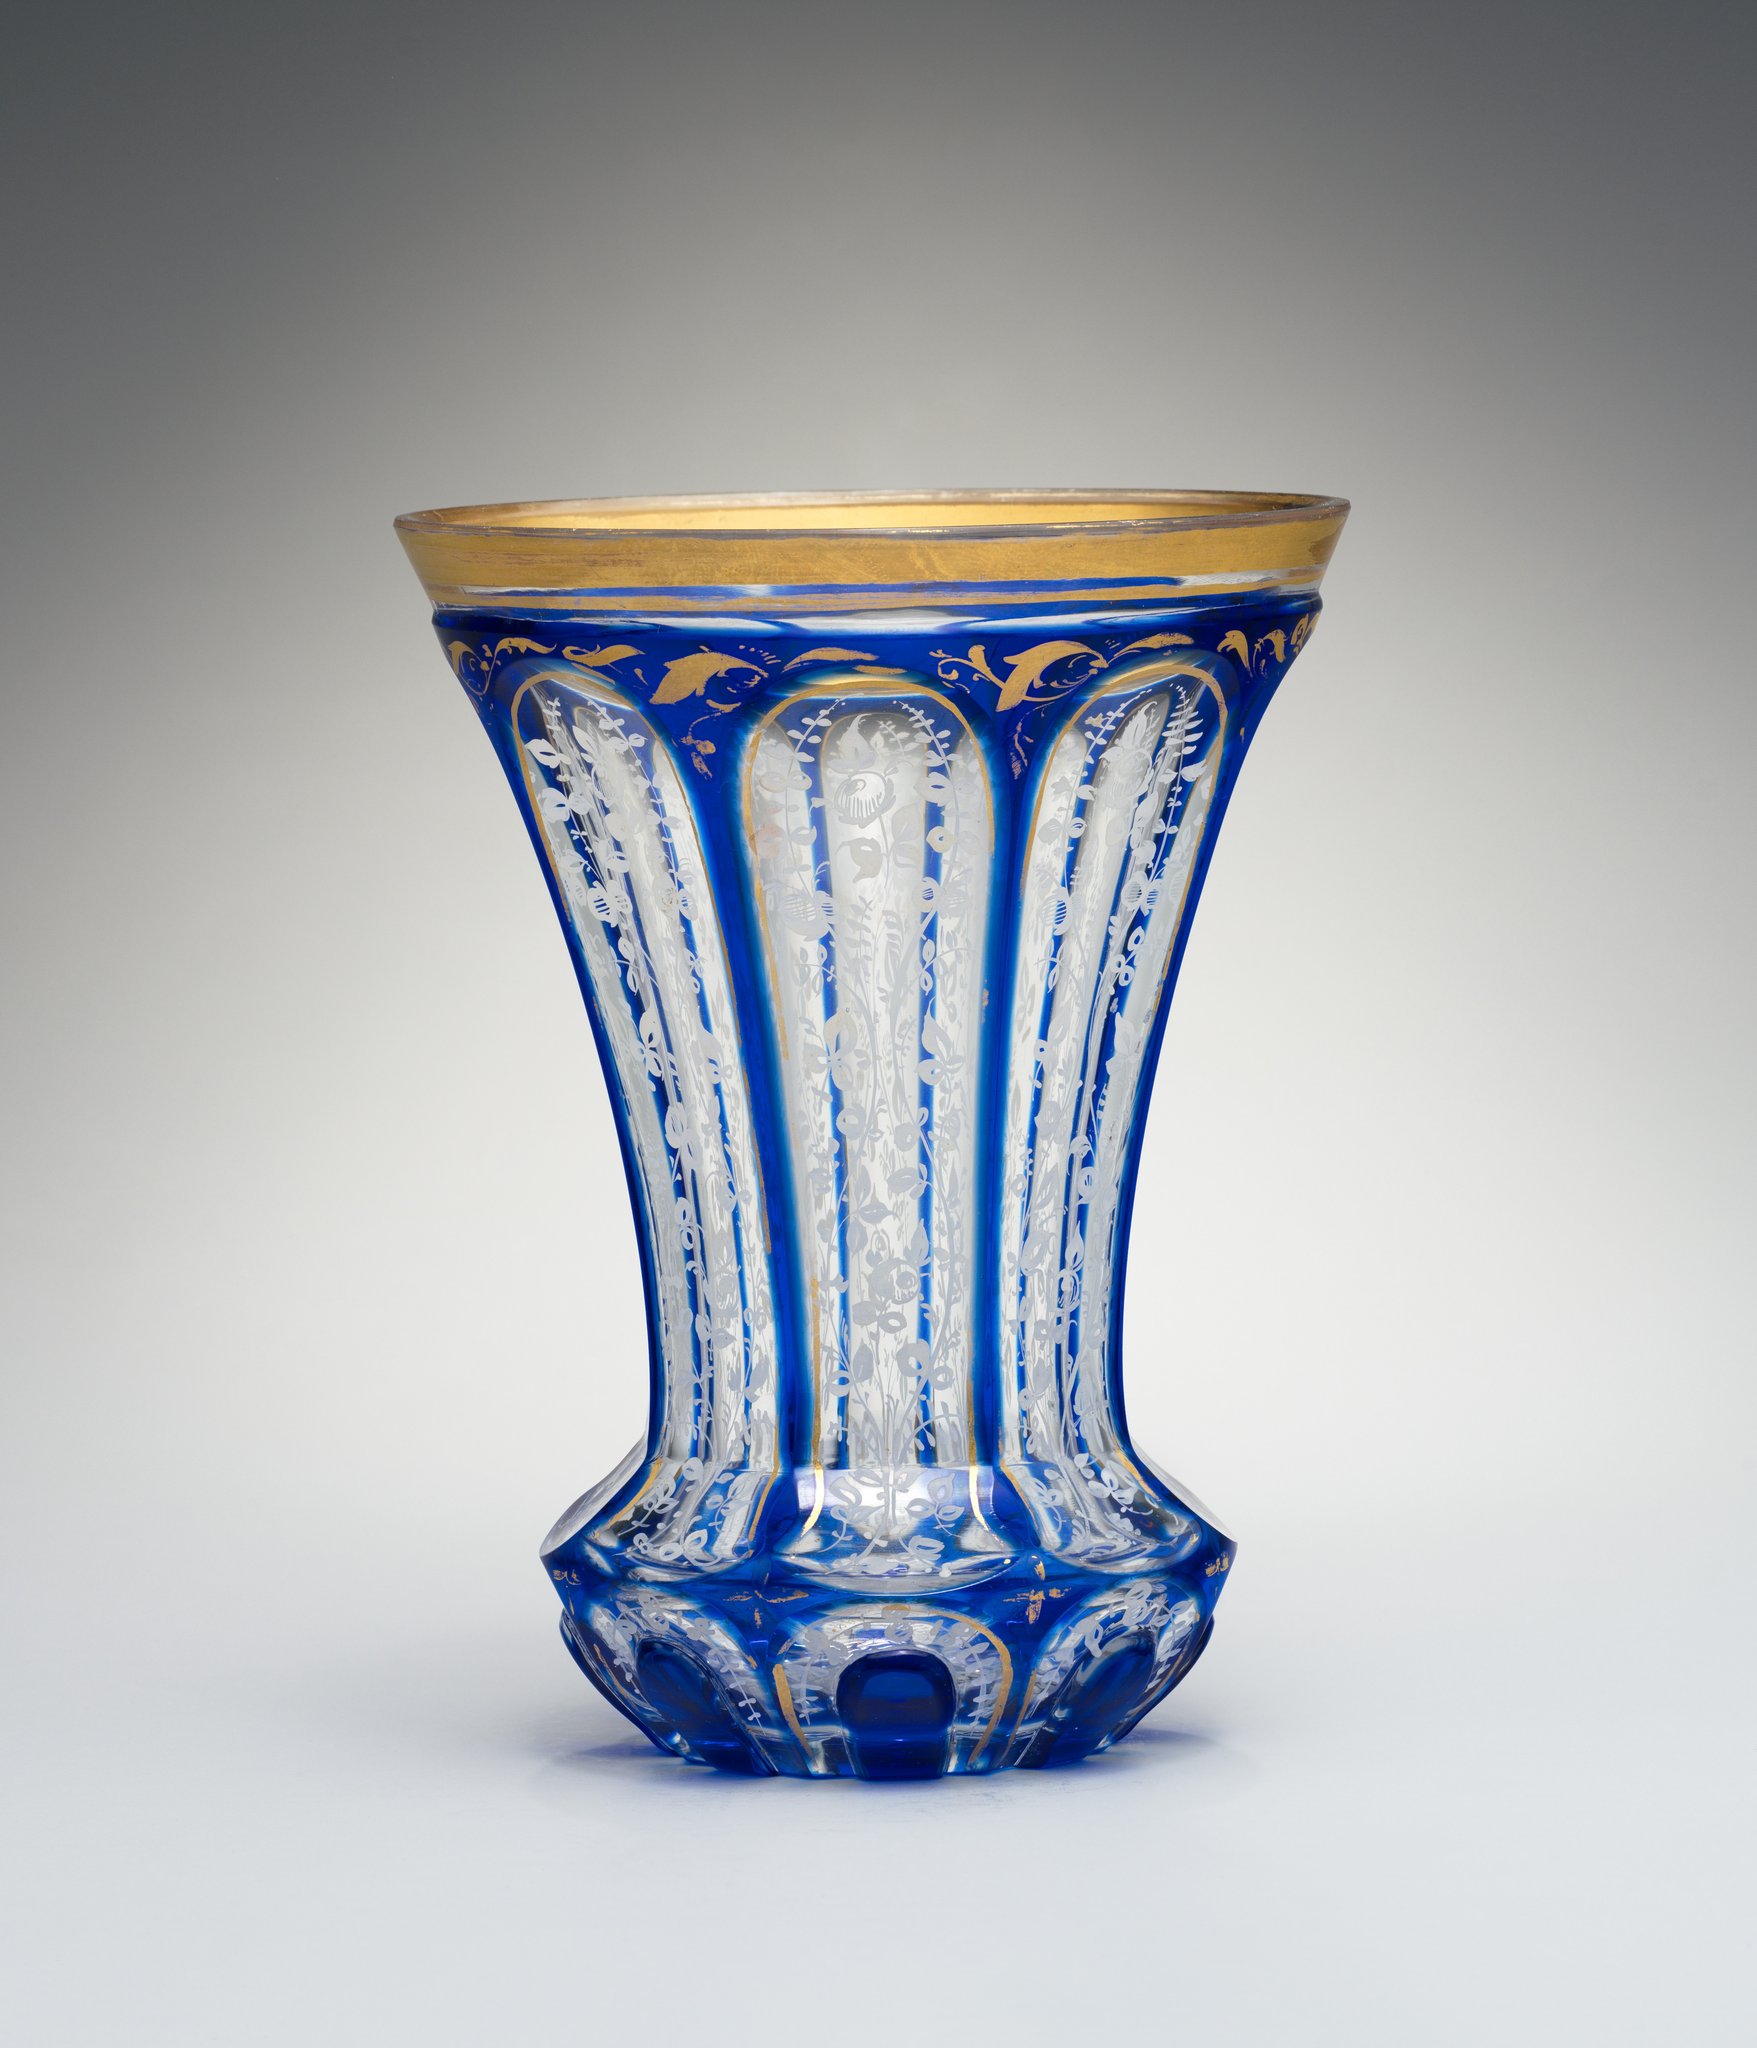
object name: beaker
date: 1840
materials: glass